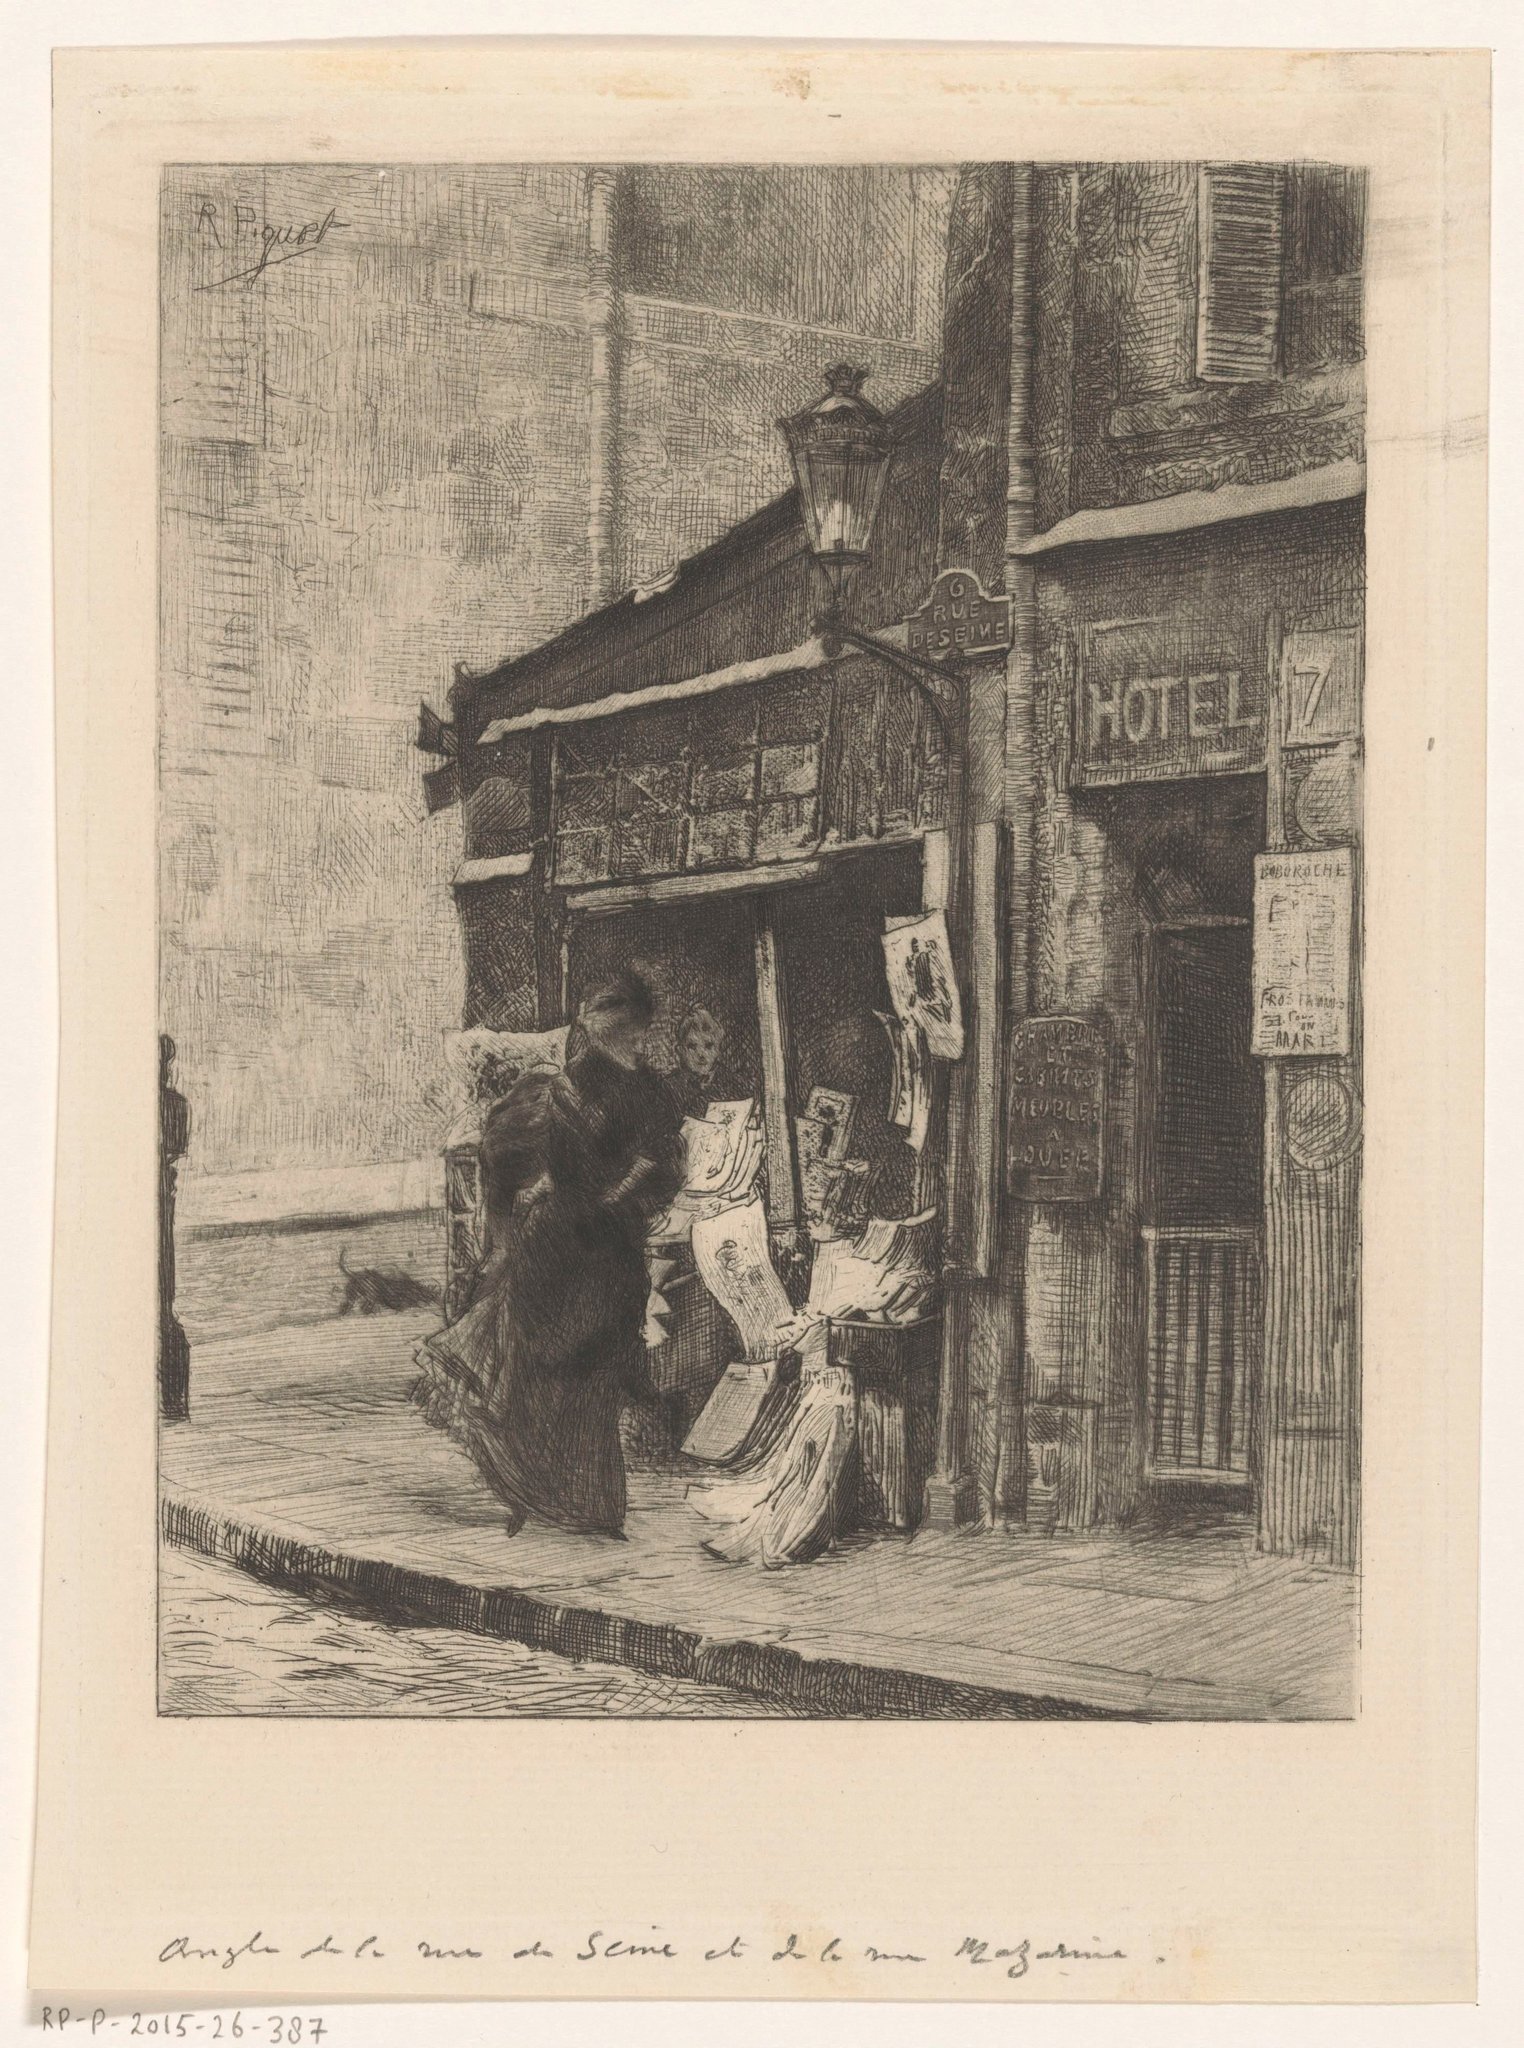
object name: print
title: Prentwinkel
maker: rodolphe piguet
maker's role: draughtsman, painter, print maker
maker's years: 1840-1915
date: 1900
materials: paper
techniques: drypoint, etching, roulette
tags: print, e.g.: engraving, etching, lithograph, art dealer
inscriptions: collector's mark: Lugt 2228, collector's mark: Lugt 4780, annotation: ‘angle de la rue de Seine et de la rue Mazarine’, collector's mark: Lugt 4779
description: Gezicht op het exterieur van een prentwinkel aan de Rue de Seine, op de hoek met de Rue Mazarine. Een vrouw passeert de winkel waar tal van prenten in de deuropening hangen.